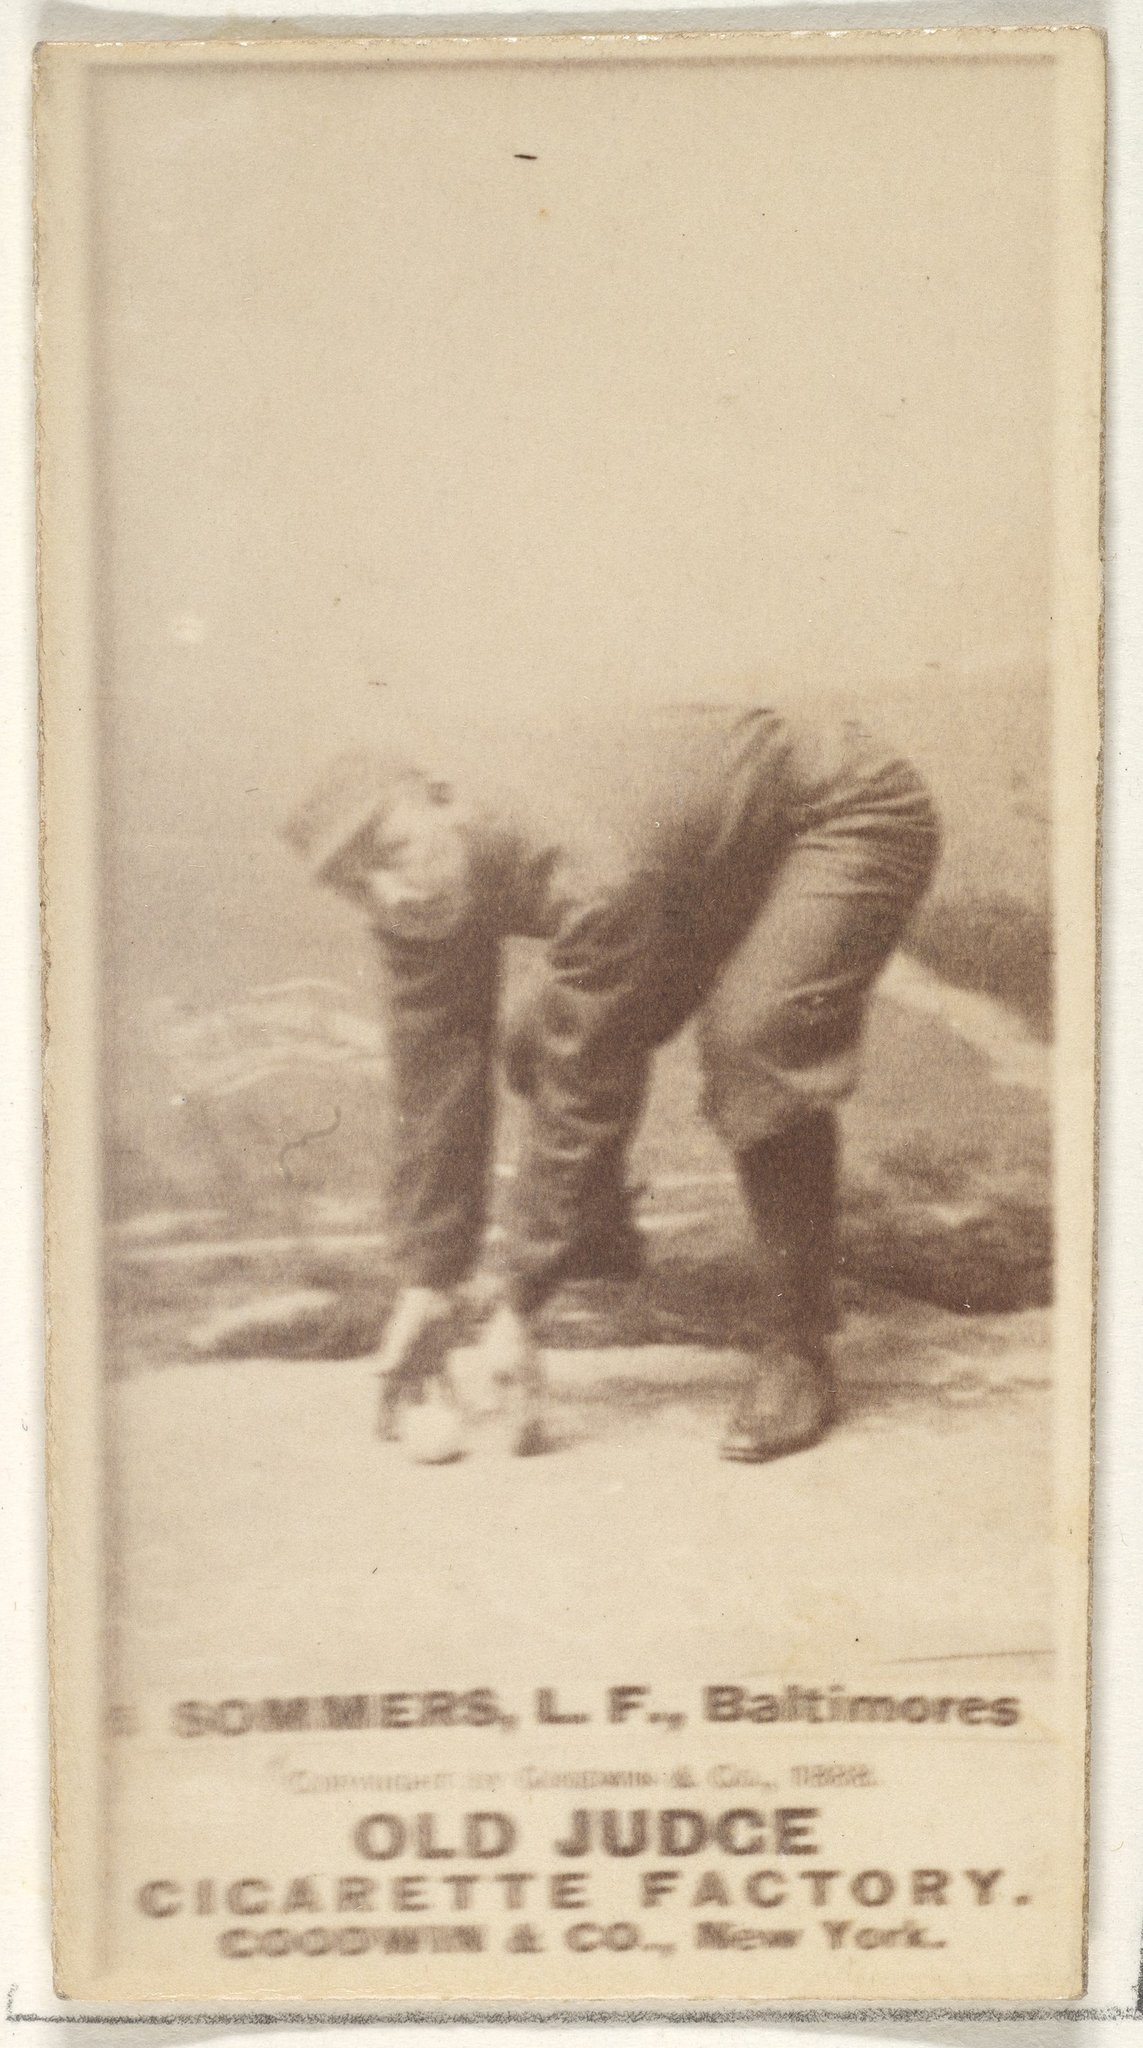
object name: baseball card, photograph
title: Sommers, Left Field, Baltimore Orioles, from the Old Judge series (N172) for Old Judge Cigarettes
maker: goodwin & company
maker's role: publisher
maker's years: 1850-1950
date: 1888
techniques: albumen silver print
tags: men,portraits,baseball,athletes